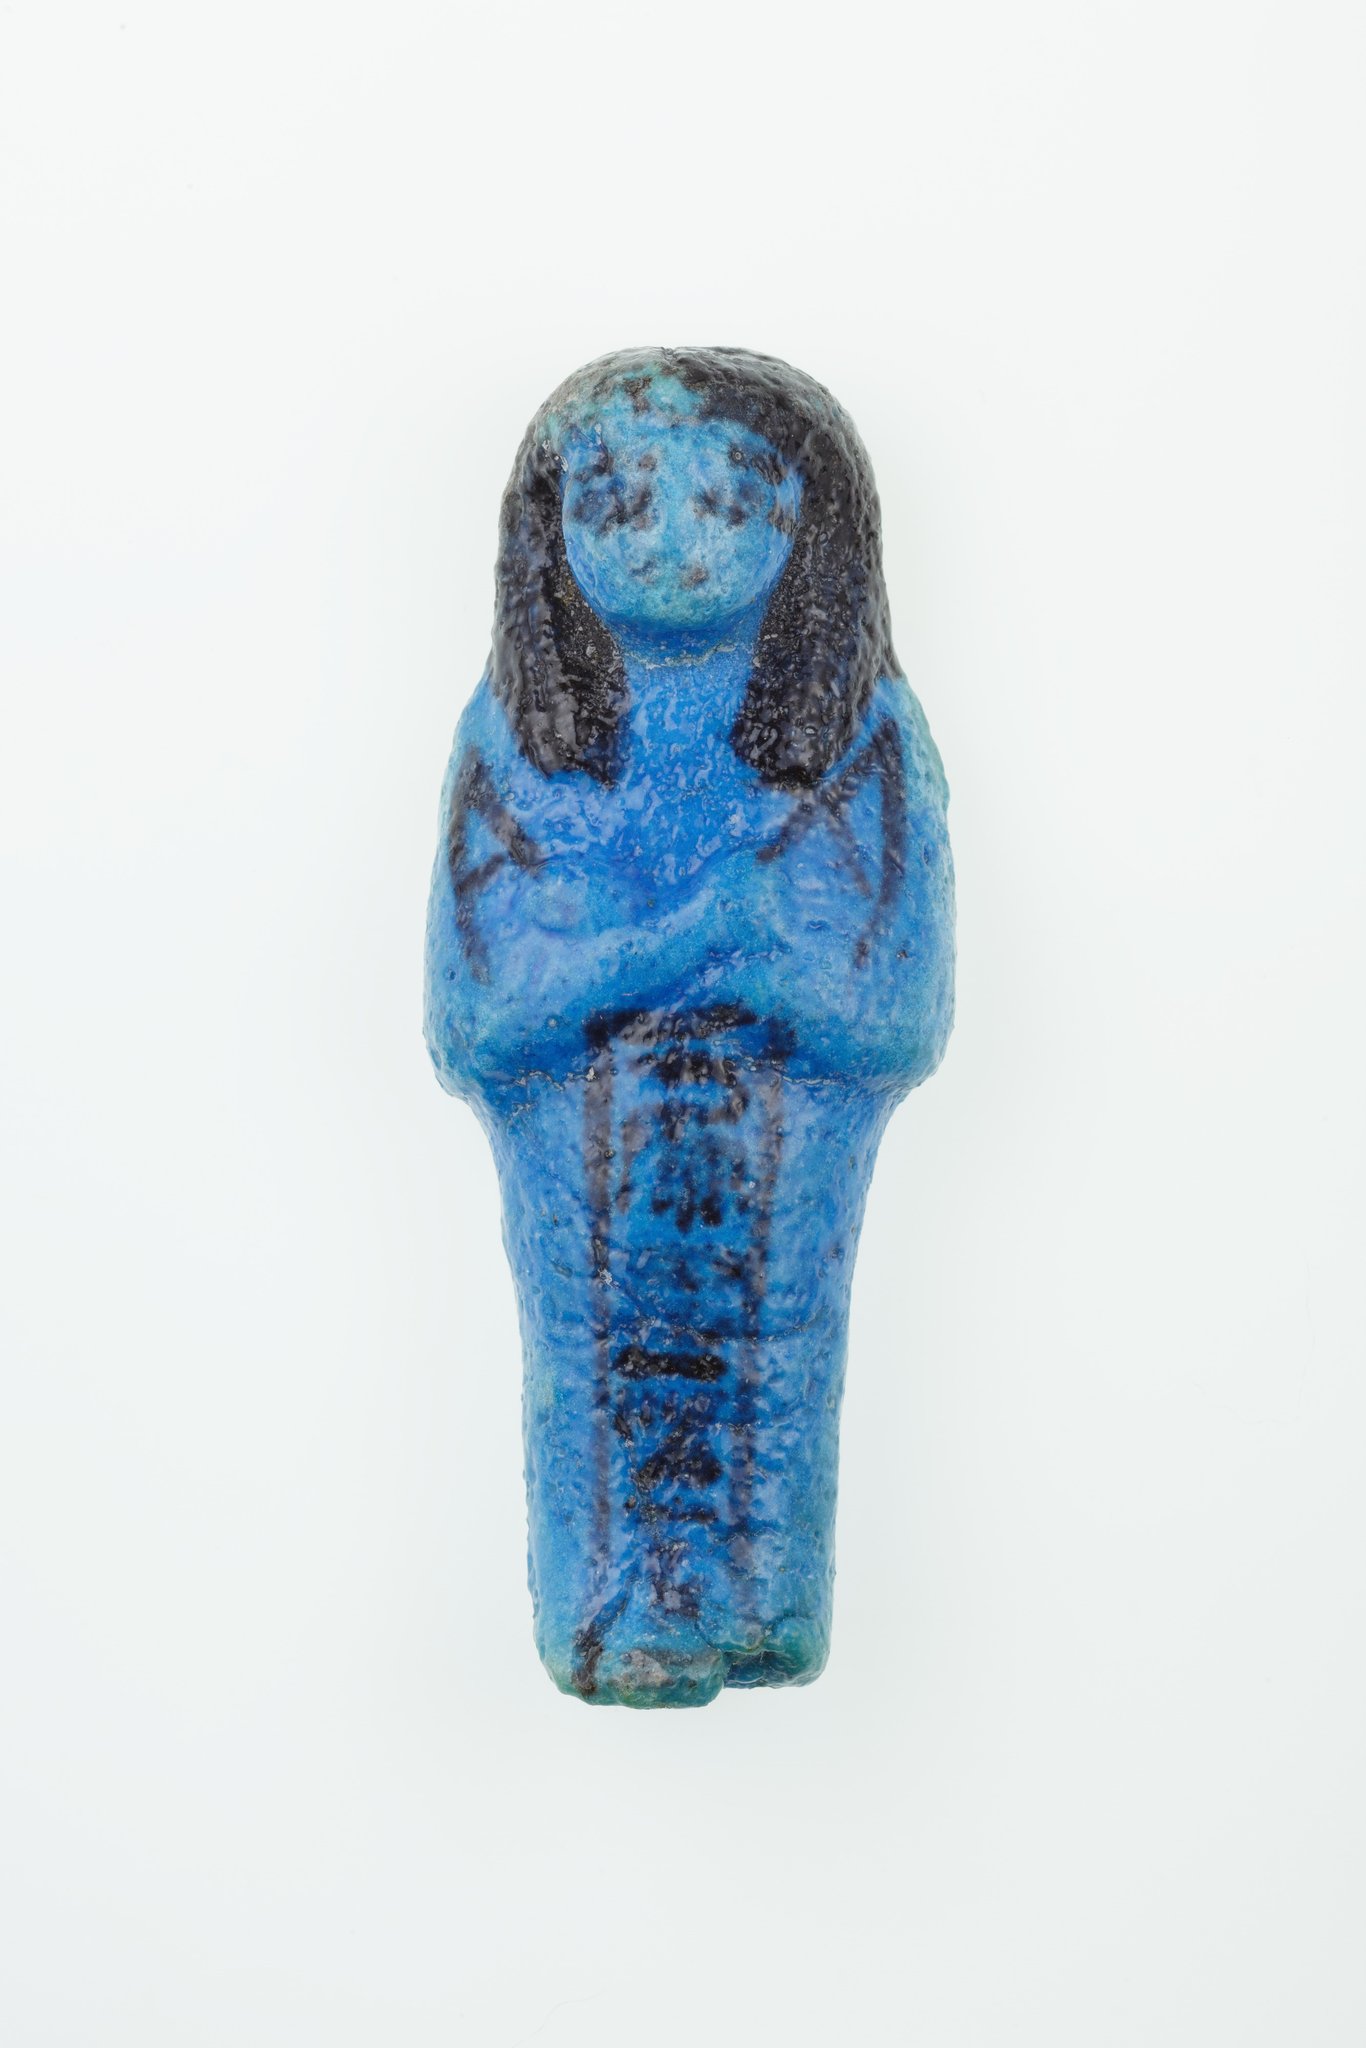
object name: shabti, worker, nauny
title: Worker Shabti of Nauny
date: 1050 BCE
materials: faience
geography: egypt